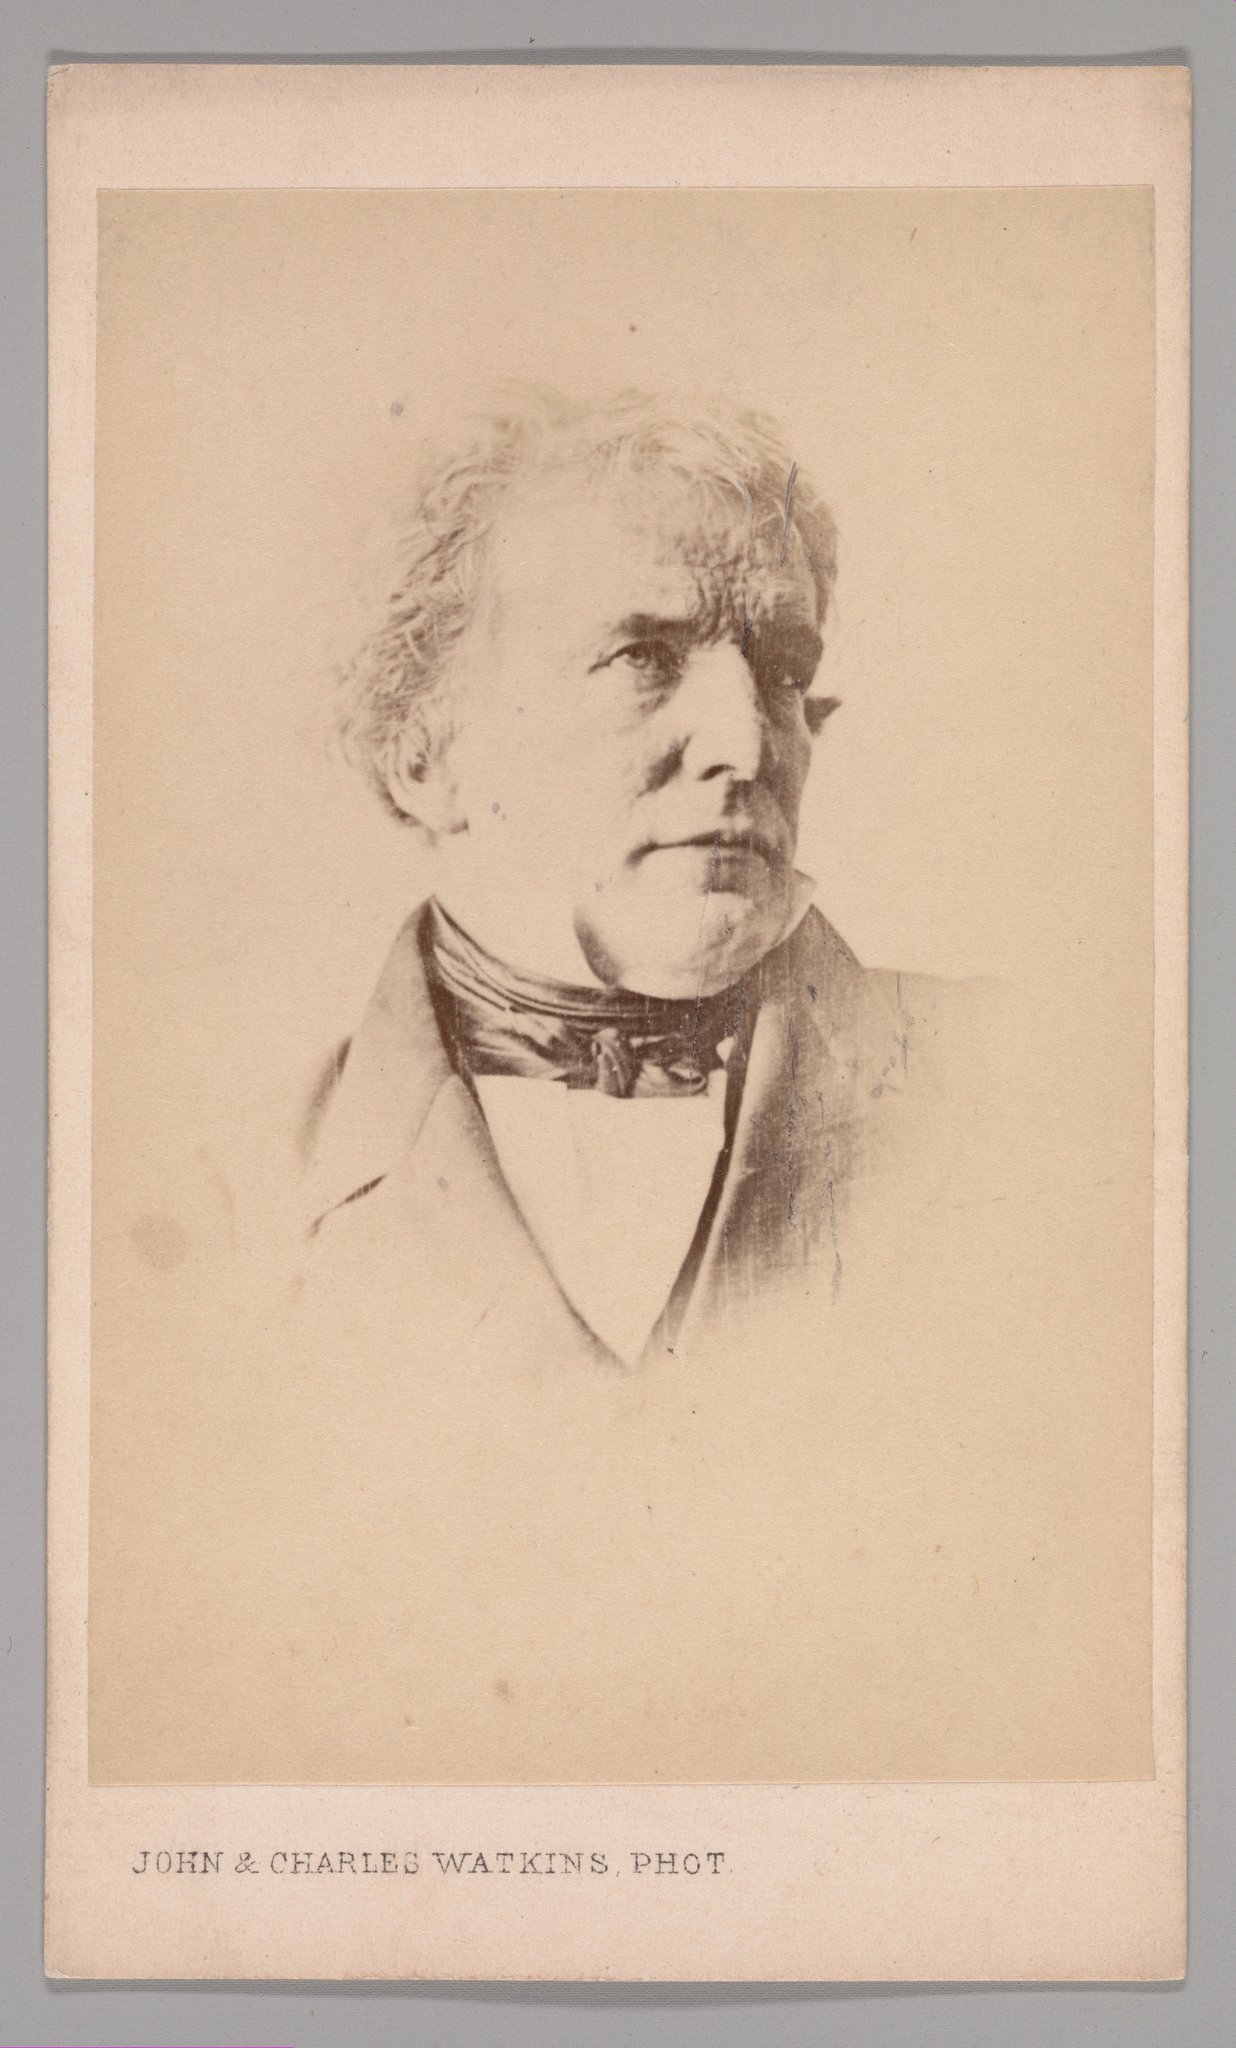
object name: carte de visite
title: [William Etty]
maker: john and charles watkins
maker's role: photography studio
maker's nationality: british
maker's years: 1840-1875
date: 1860-1869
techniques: albumen silver print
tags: men,portraits